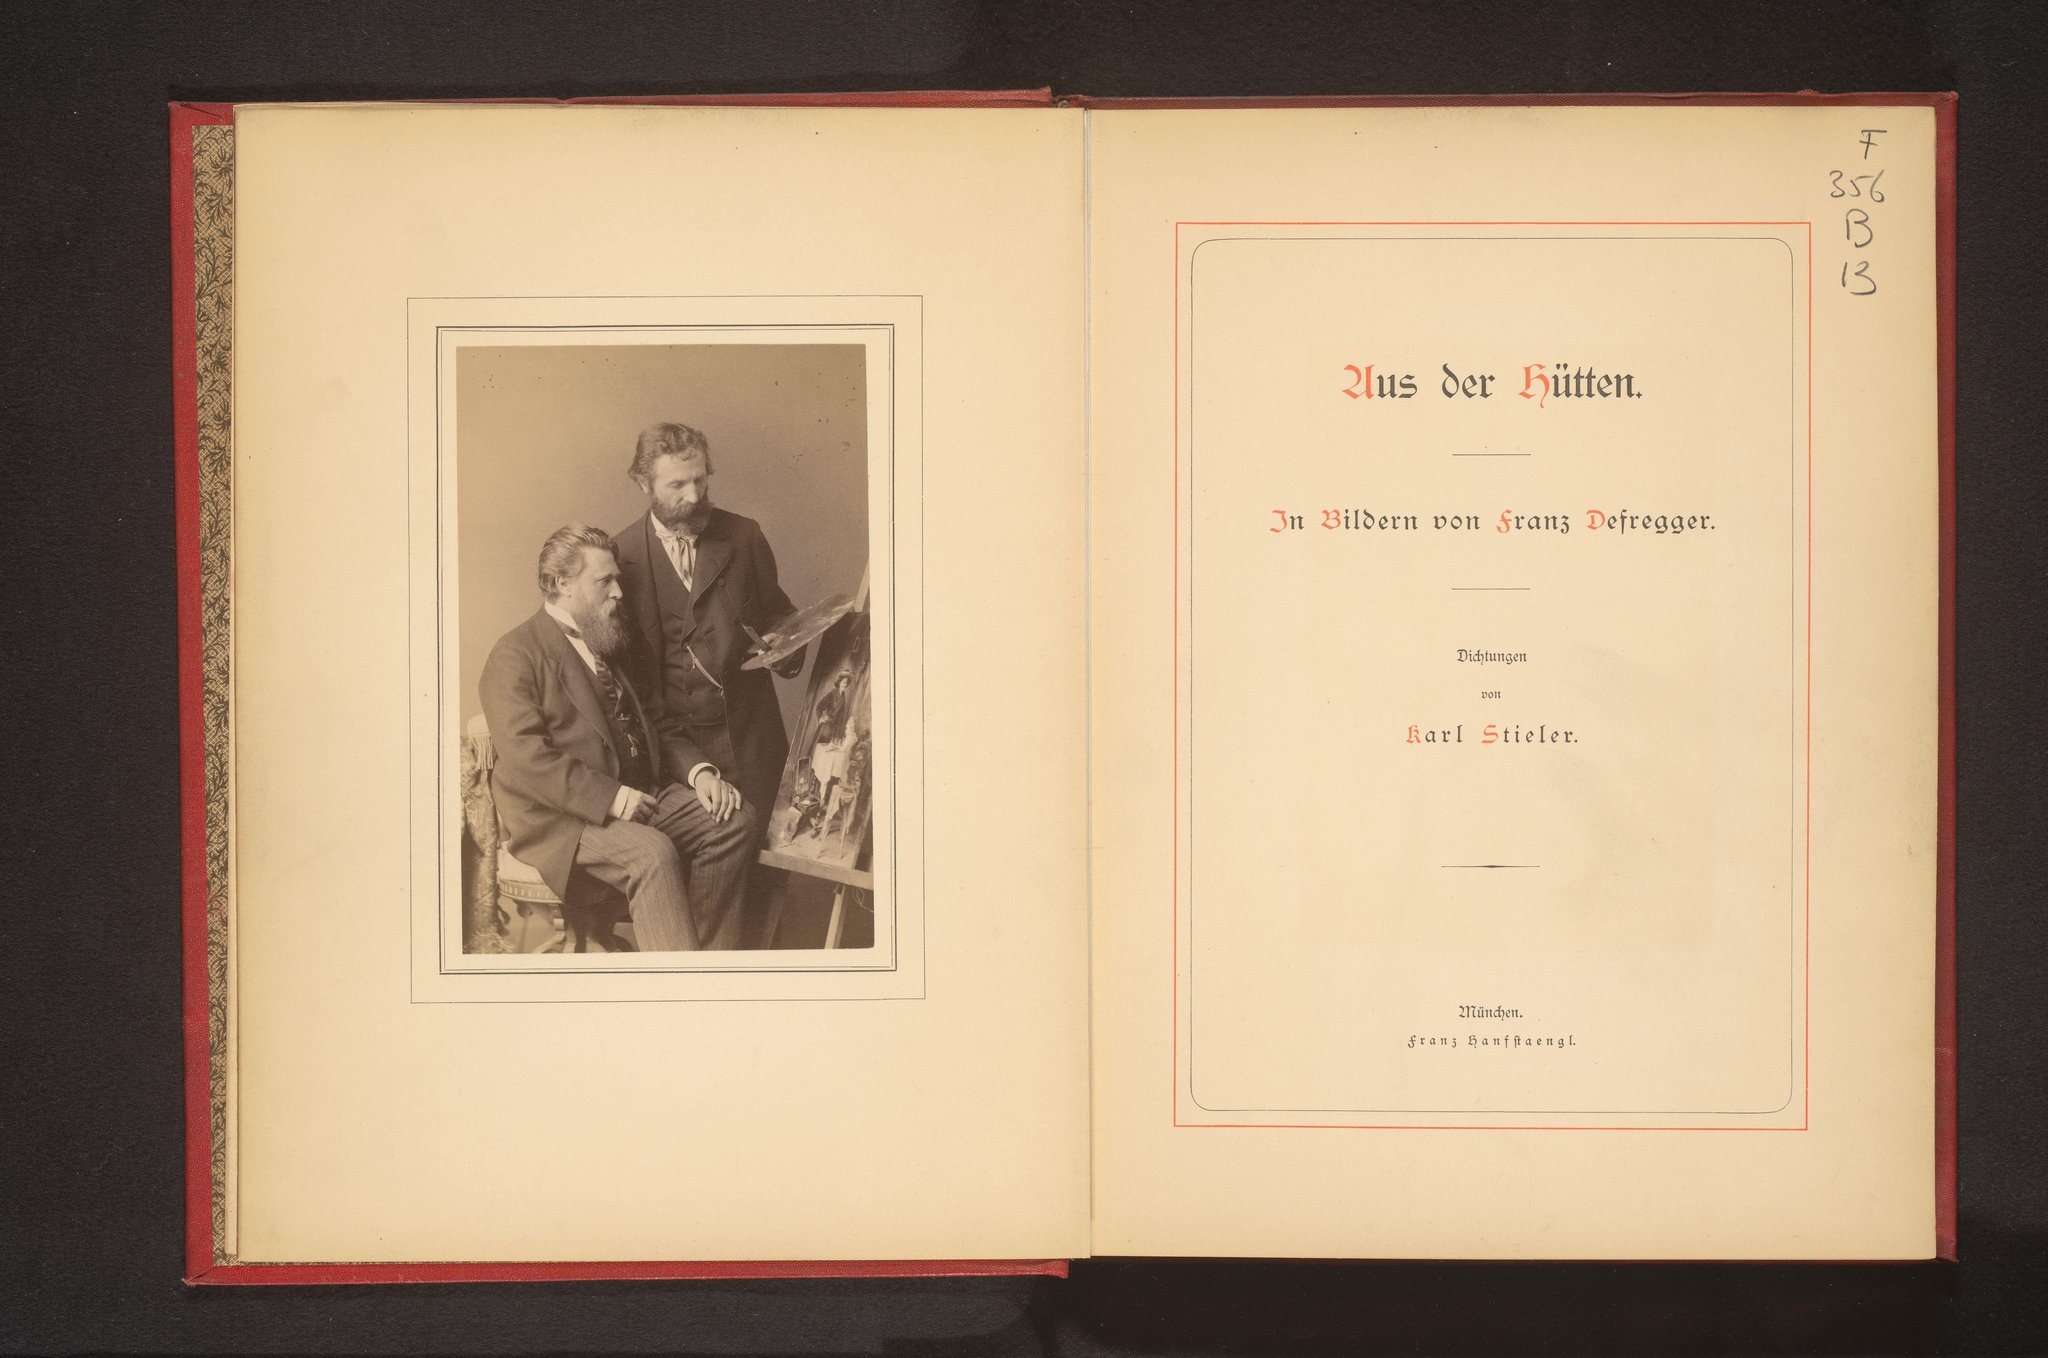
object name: photograph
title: Portret van Franz von Defregger en Karl Stieler naast een schildersezel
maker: franz seraph hanfstaengl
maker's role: painter, print maker, printer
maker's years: 1804-1877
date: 1873-1883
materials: photographic support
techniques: albumen print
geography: germany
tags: karl stieler, franz von defregger, portrait of a writer, portrait, self-portrait of artist, easel